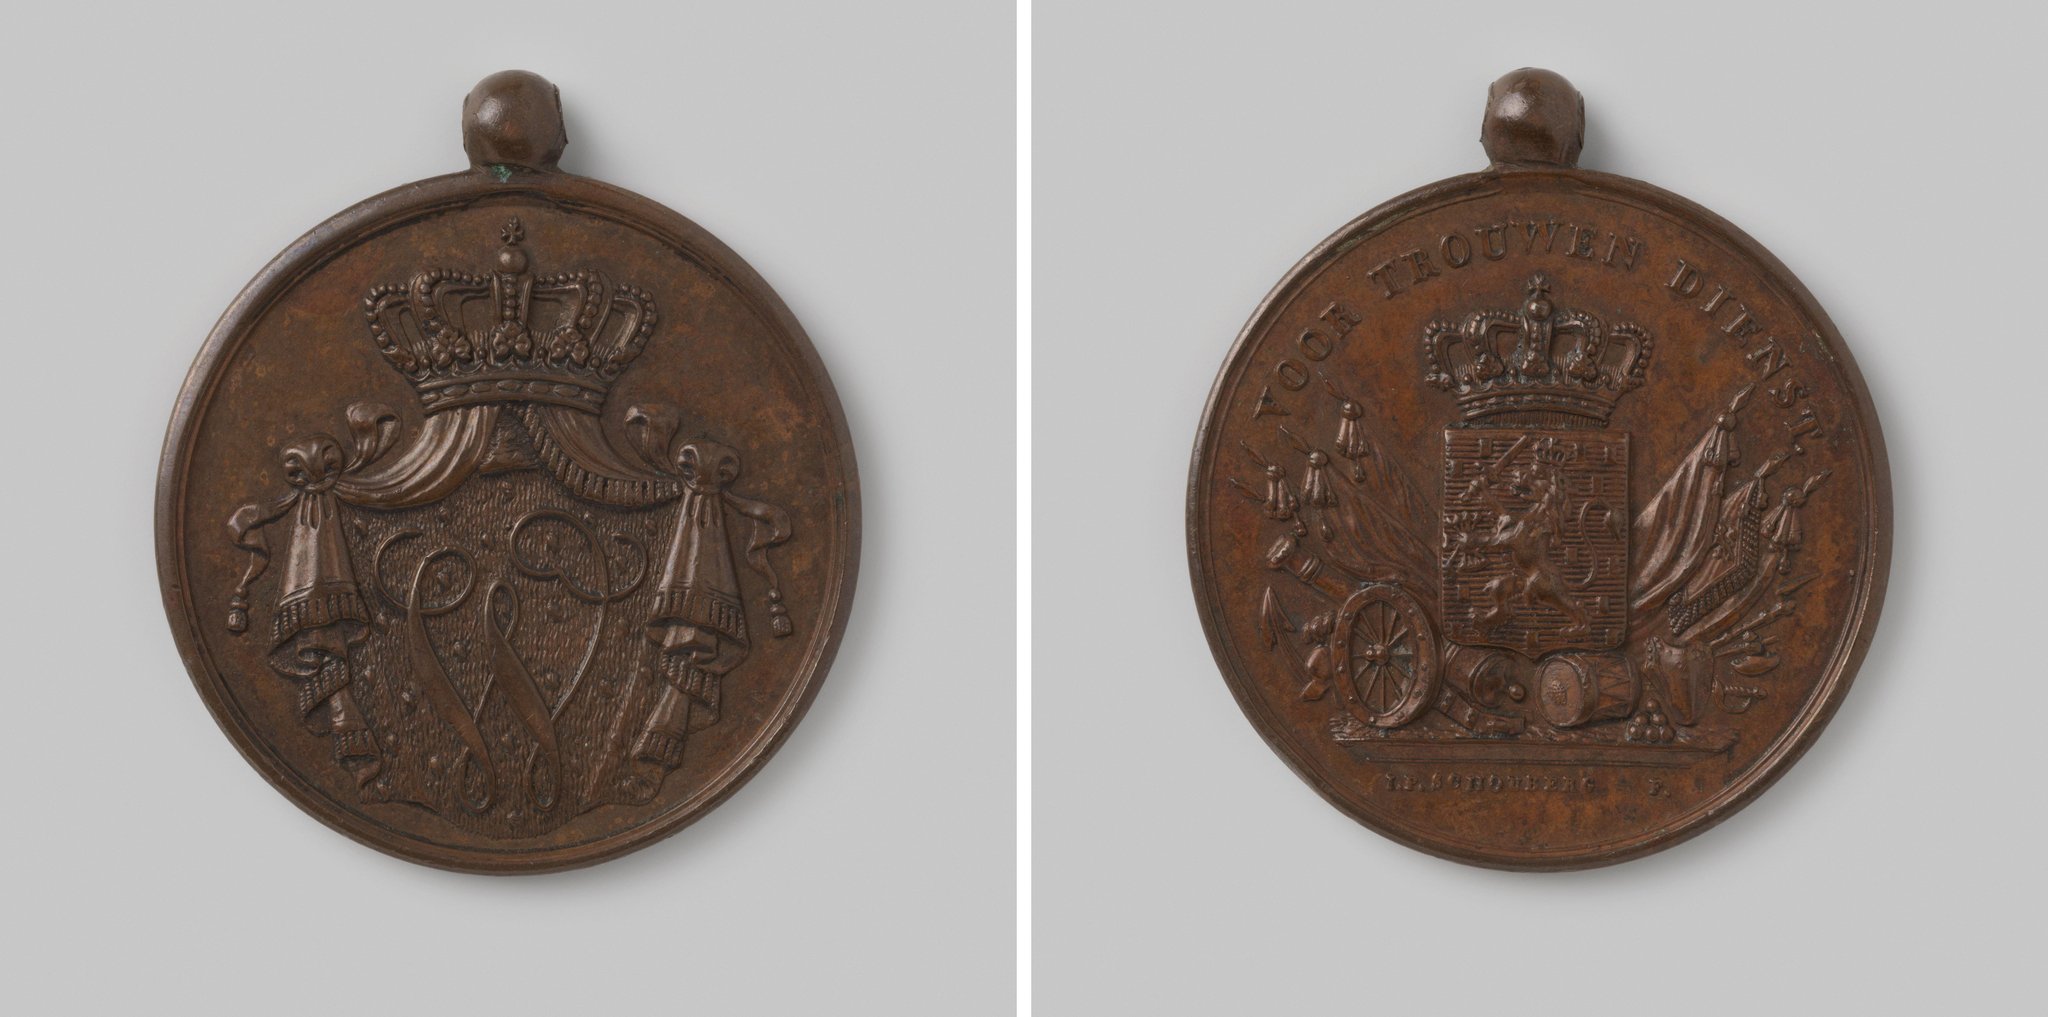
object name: history medal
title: Medaille voor trouwe dienst bij de landmacht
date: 1830-1861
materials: bronze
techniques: striking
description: Bronzen penning met bal zonder draagring, op de voorzijde sierletter W op gekroonde mantel, op de keerzijde het gekroonde Nederlandse wapenschild te midden van militaire attributen, met omschrift.